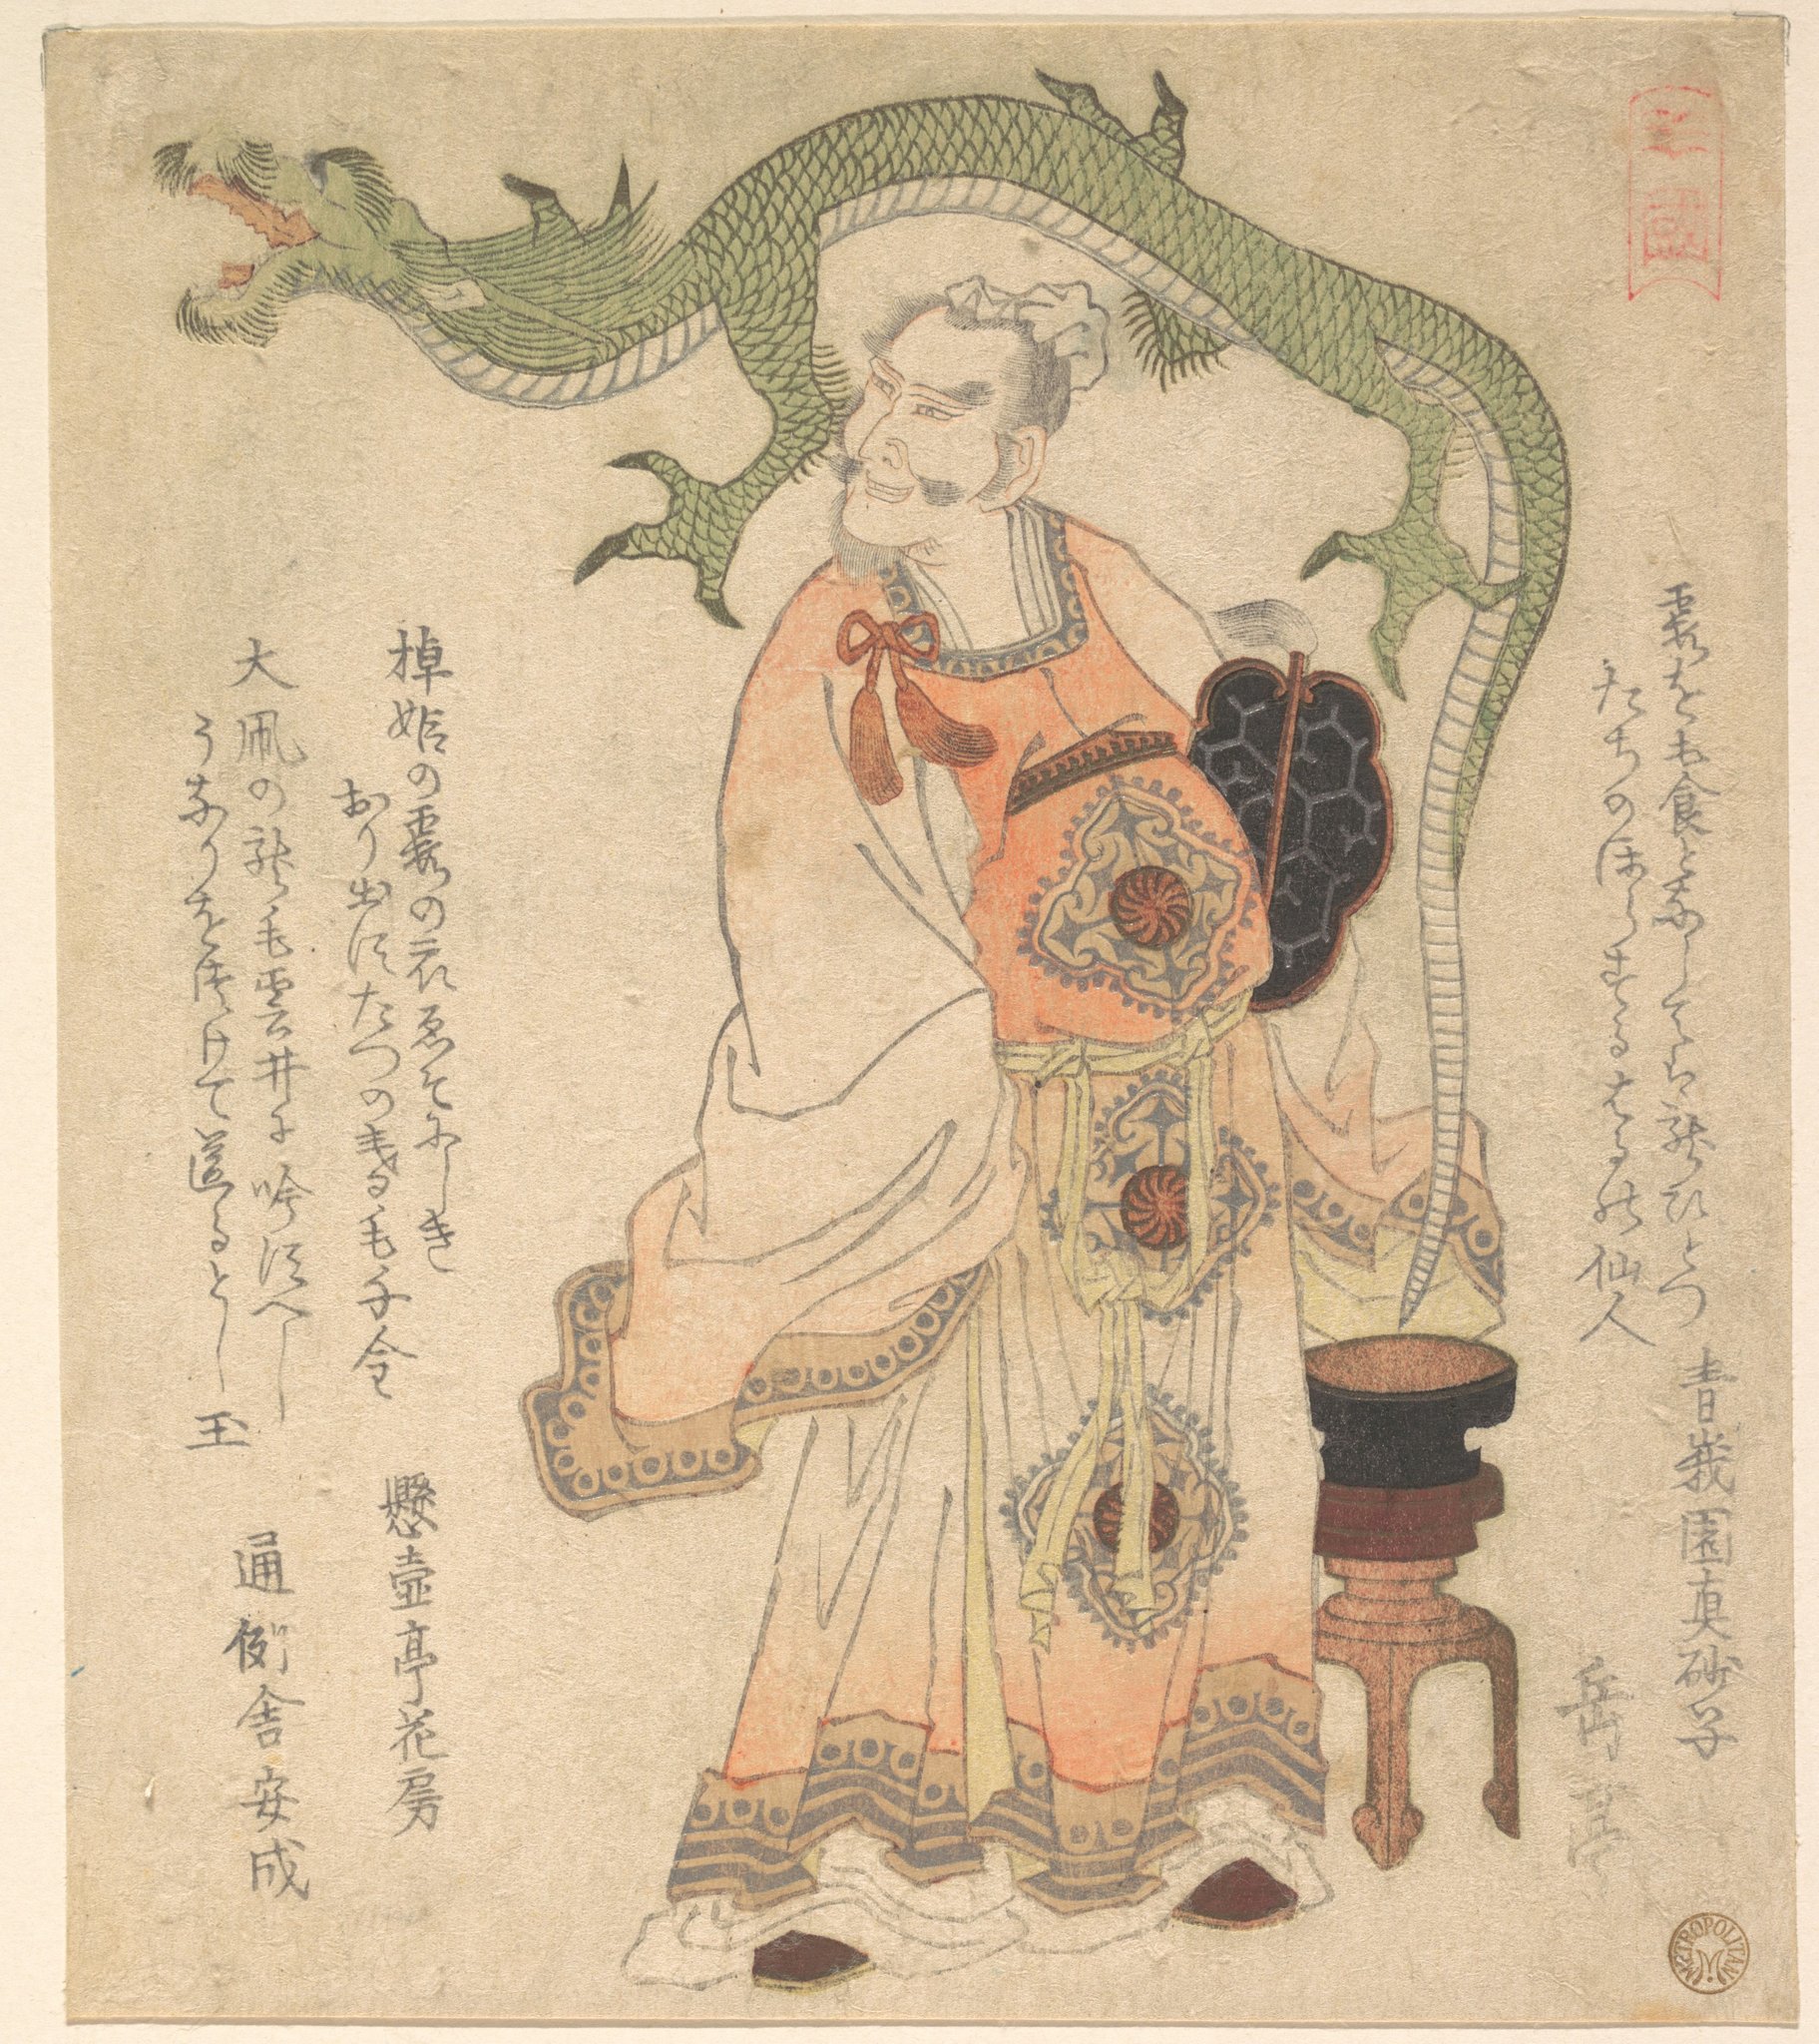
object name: print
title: Chinese Sage Evoking a Dragon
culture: japanese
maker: yashima gakutei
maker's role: artist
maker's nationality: japanese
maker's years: 1786-1868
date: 1825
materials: ink, paper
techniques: surimono, woodblock print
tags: men,dragons